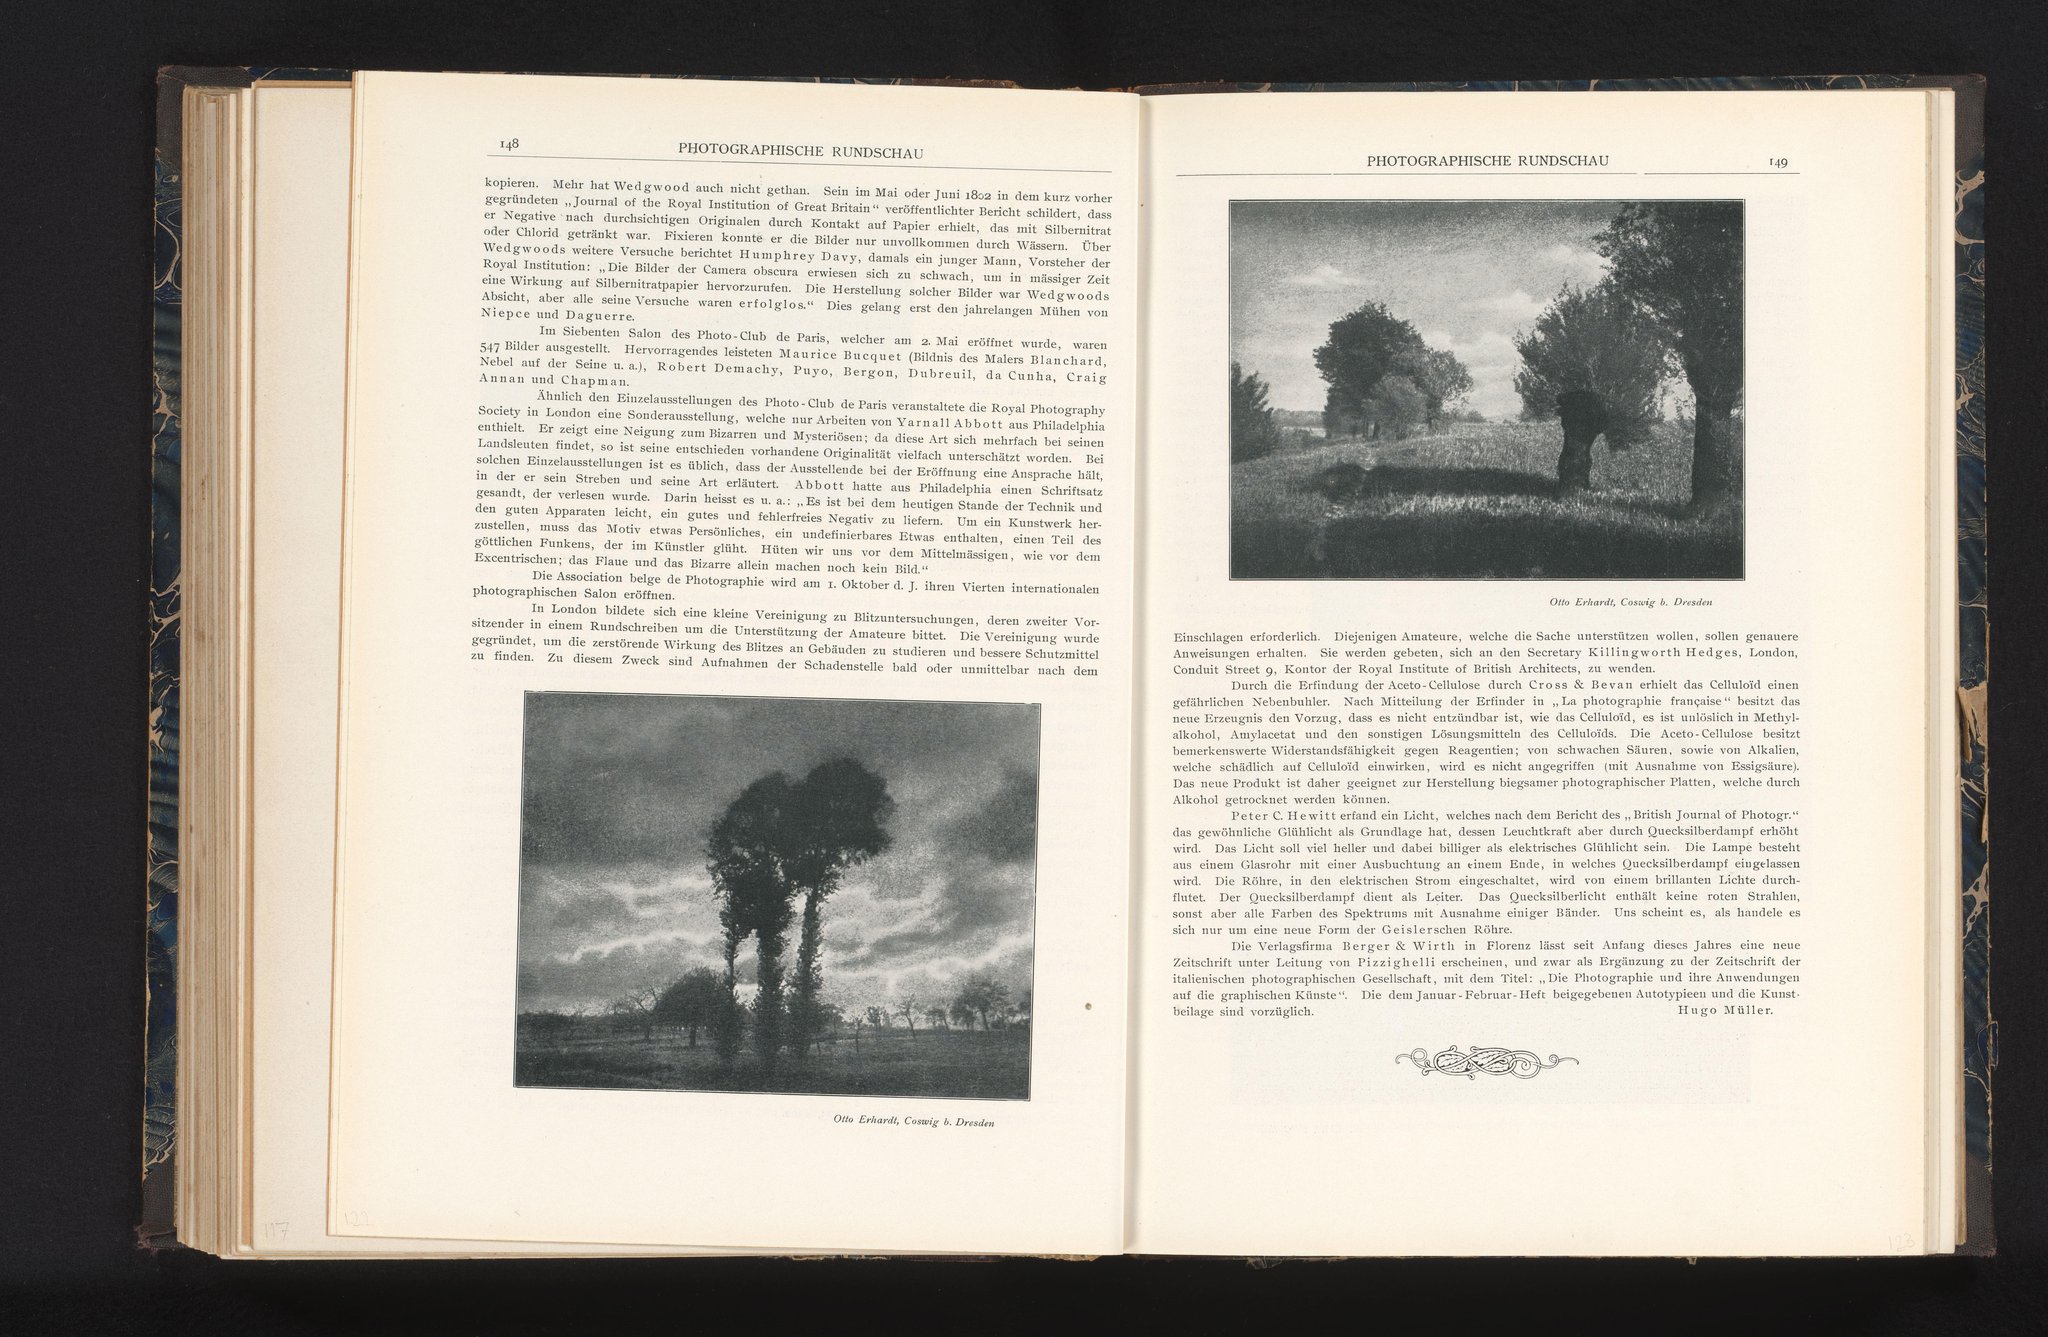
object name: page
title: Gezicht op bomen in een landschap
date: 1897-1902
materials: paper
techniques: autotype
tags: trees, landscapes